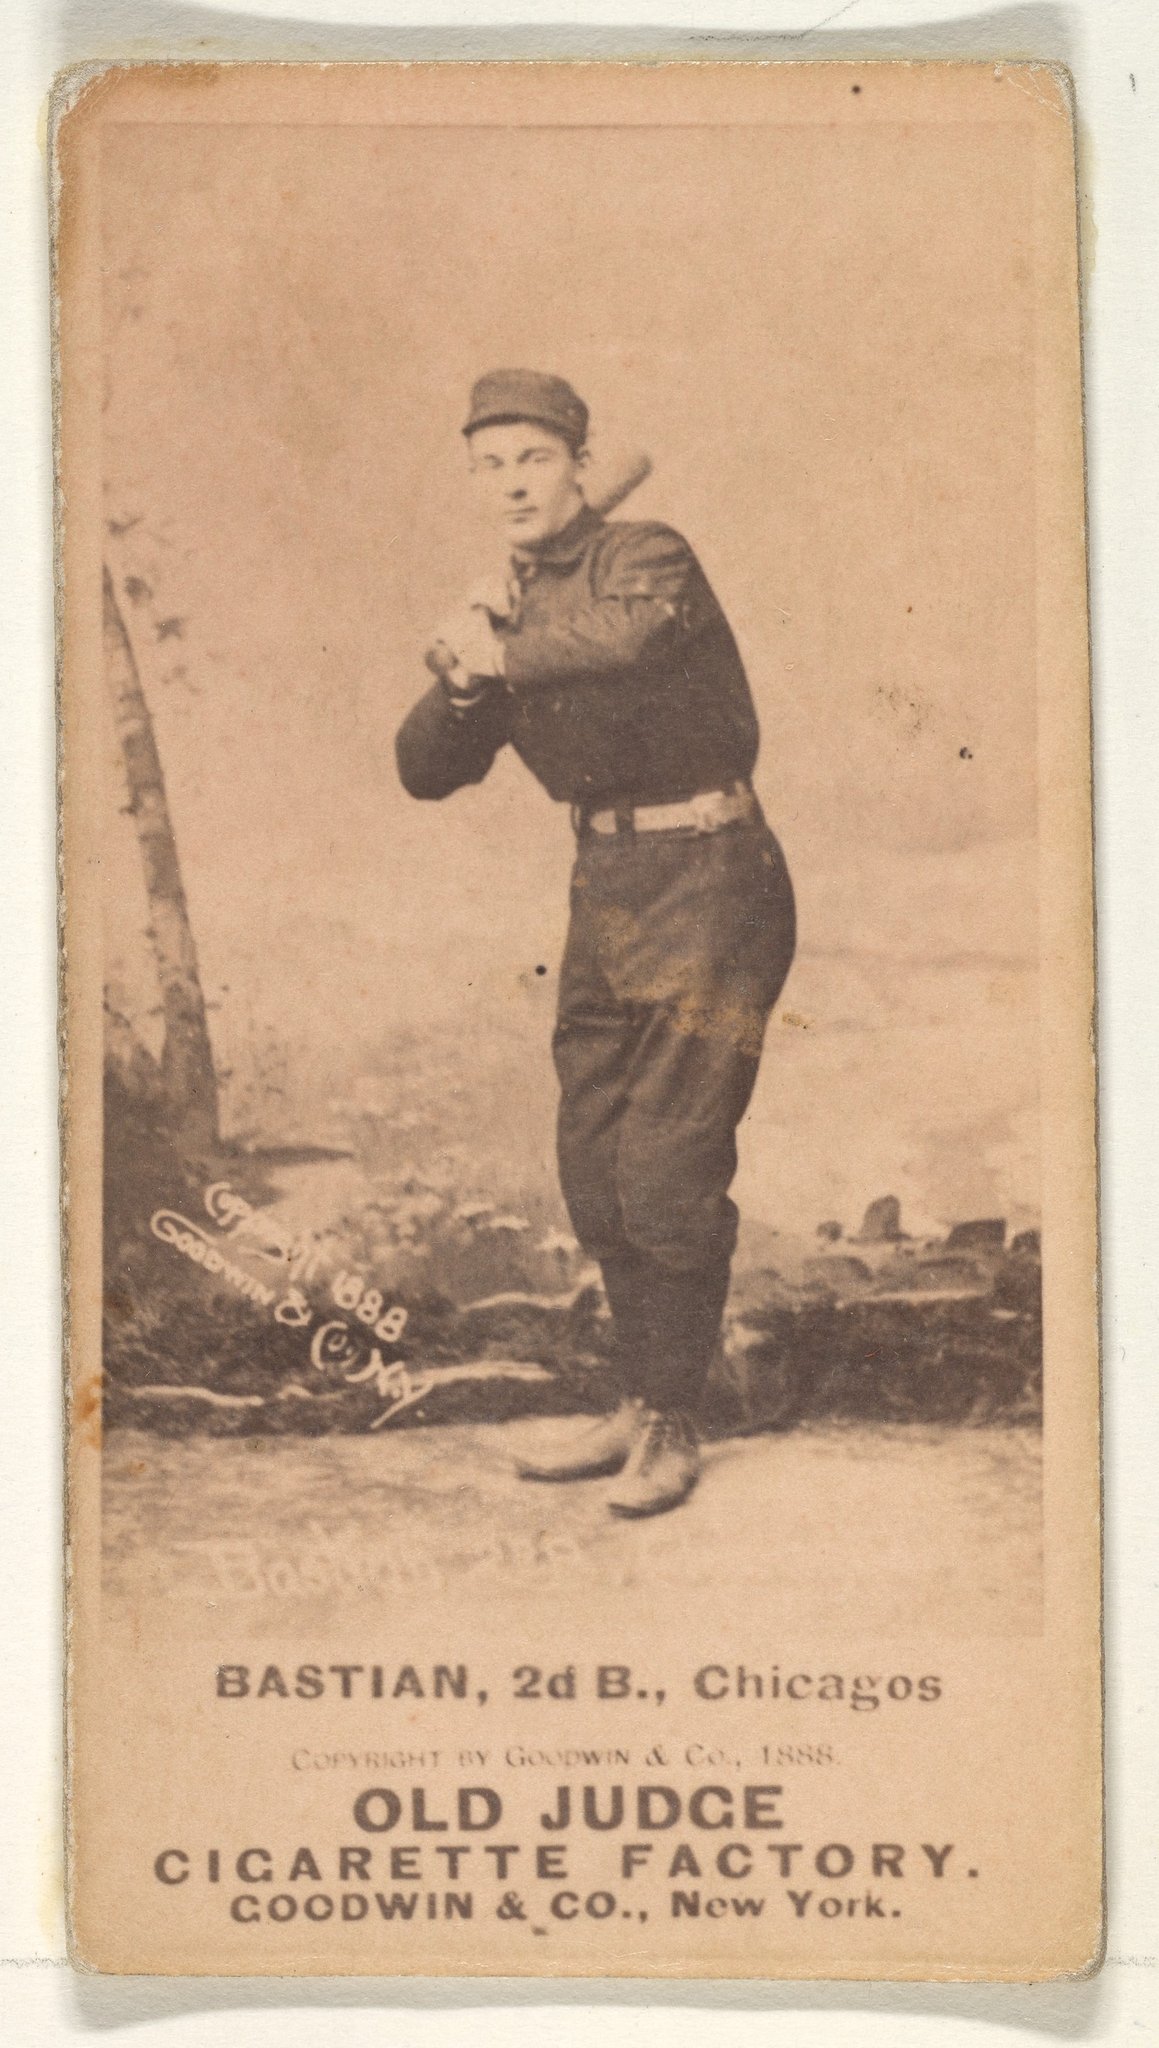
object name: baseball card, photograph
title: Bastian, 2nd Base, Chicago, from the Old Judge series (N172) for Old Judge Cigarettes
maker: goodwin & company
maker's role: publisher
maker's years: 1850-1950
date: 1888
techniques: albumen silver print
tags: men,baseball,athletes